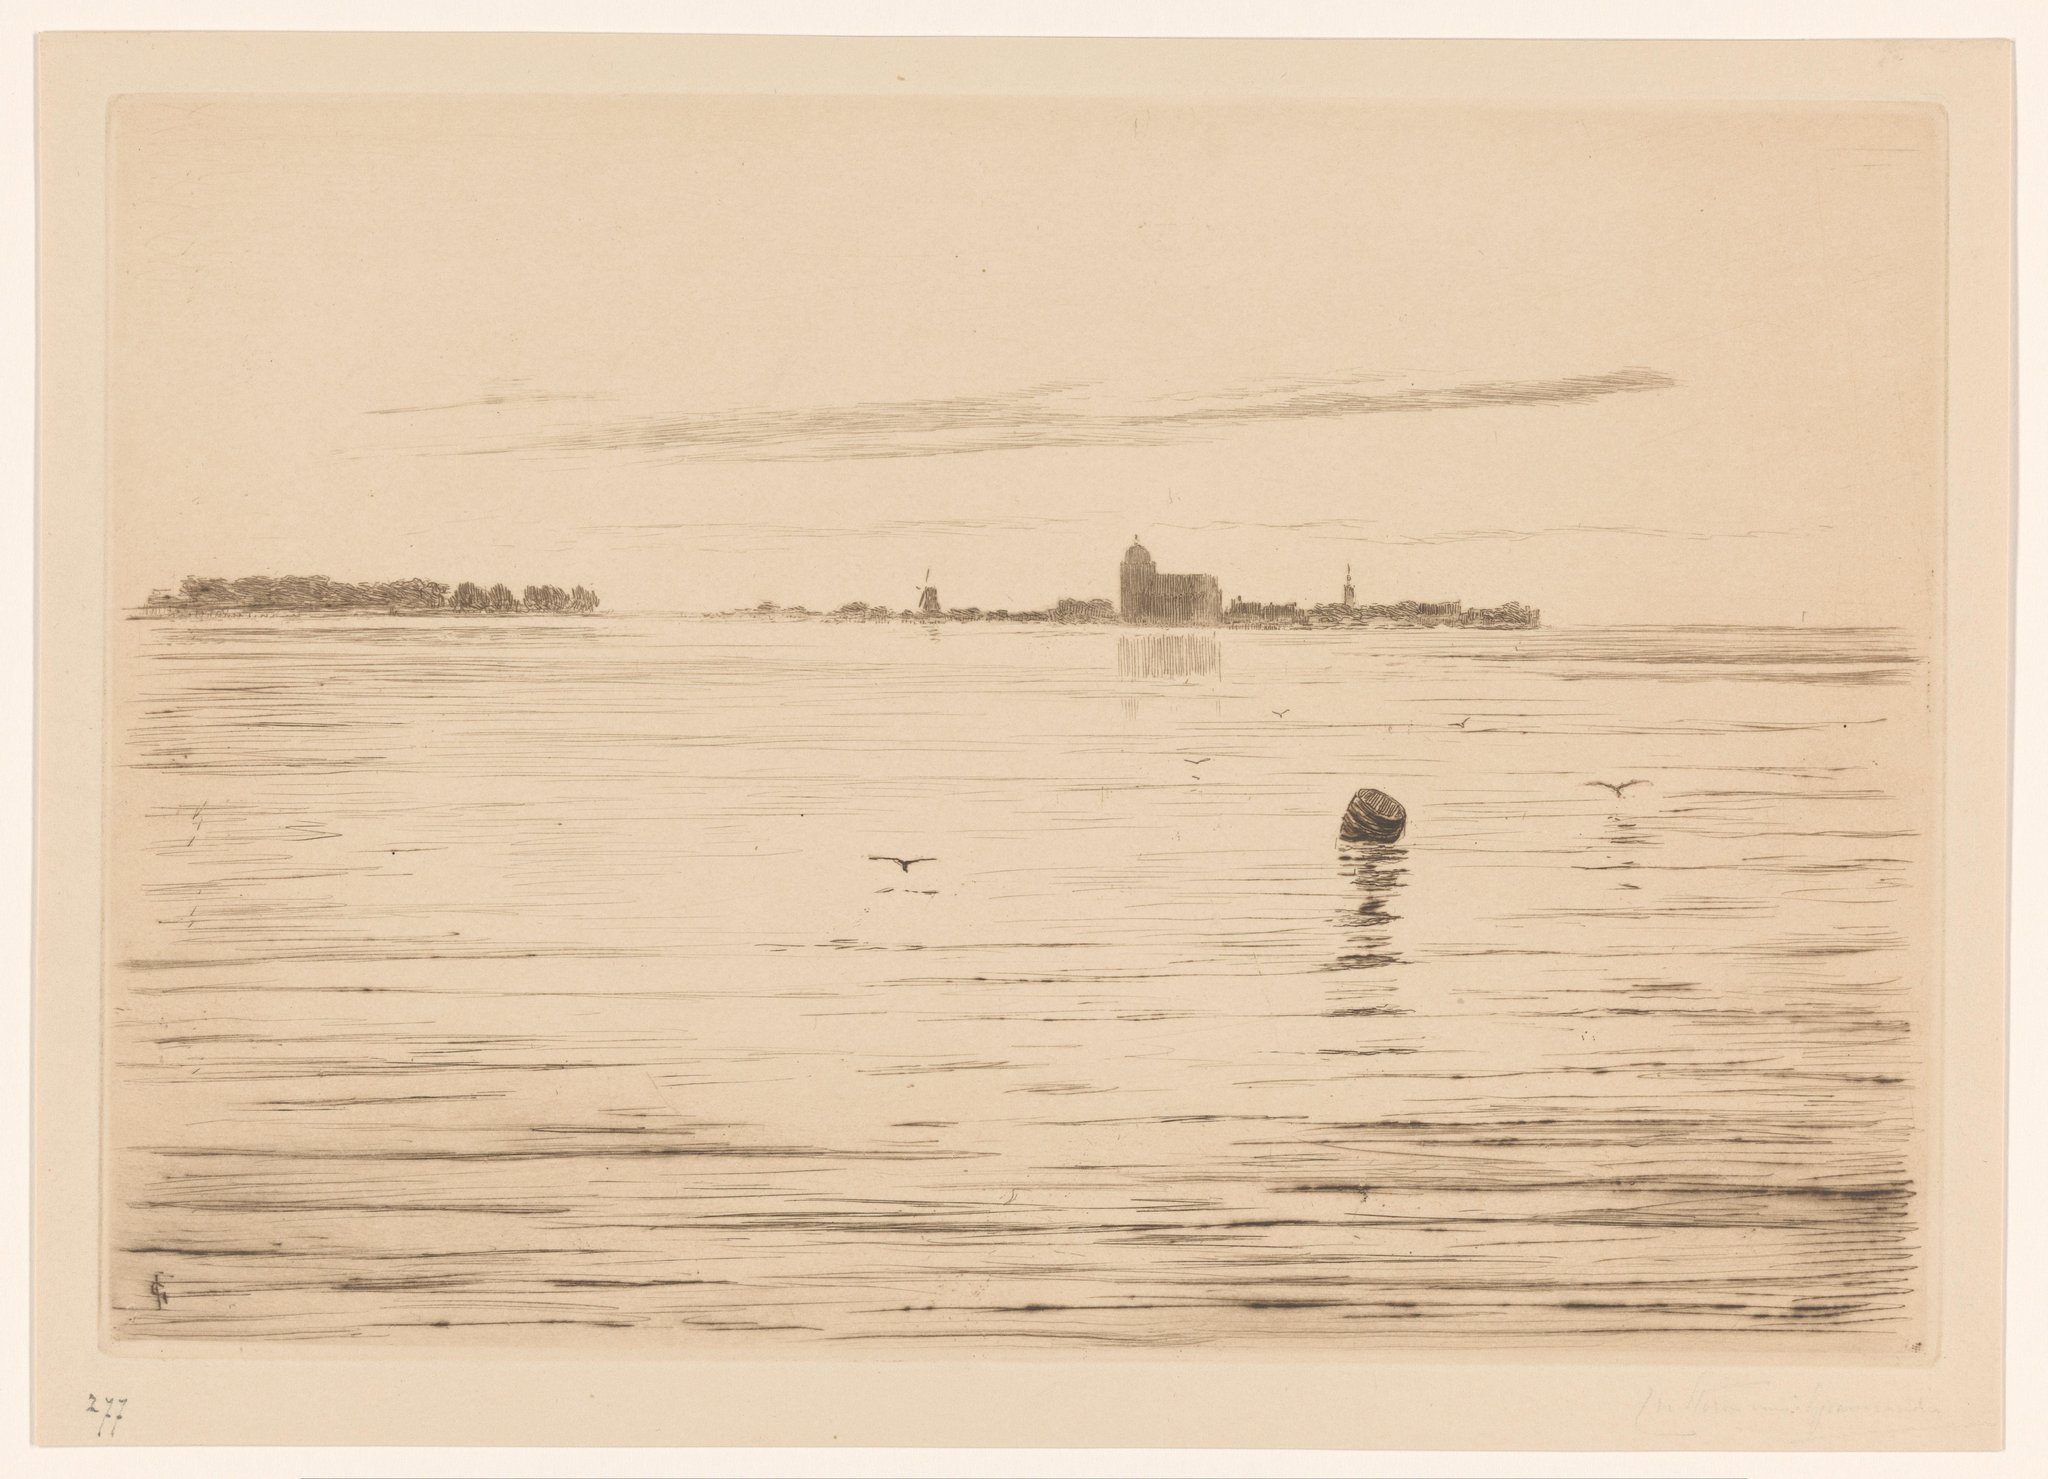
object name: print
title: L'Escaut près Veere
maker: carel nicolaas storm van s-gravesande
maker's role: draughtsman, print maker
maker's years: 1841-1924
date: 1887-1889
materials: paper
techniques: drypoint, etching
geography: netherlands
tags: prospect of village, silhouette of village, river, church (exterior)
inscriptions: collector's mark: Lugt 2228